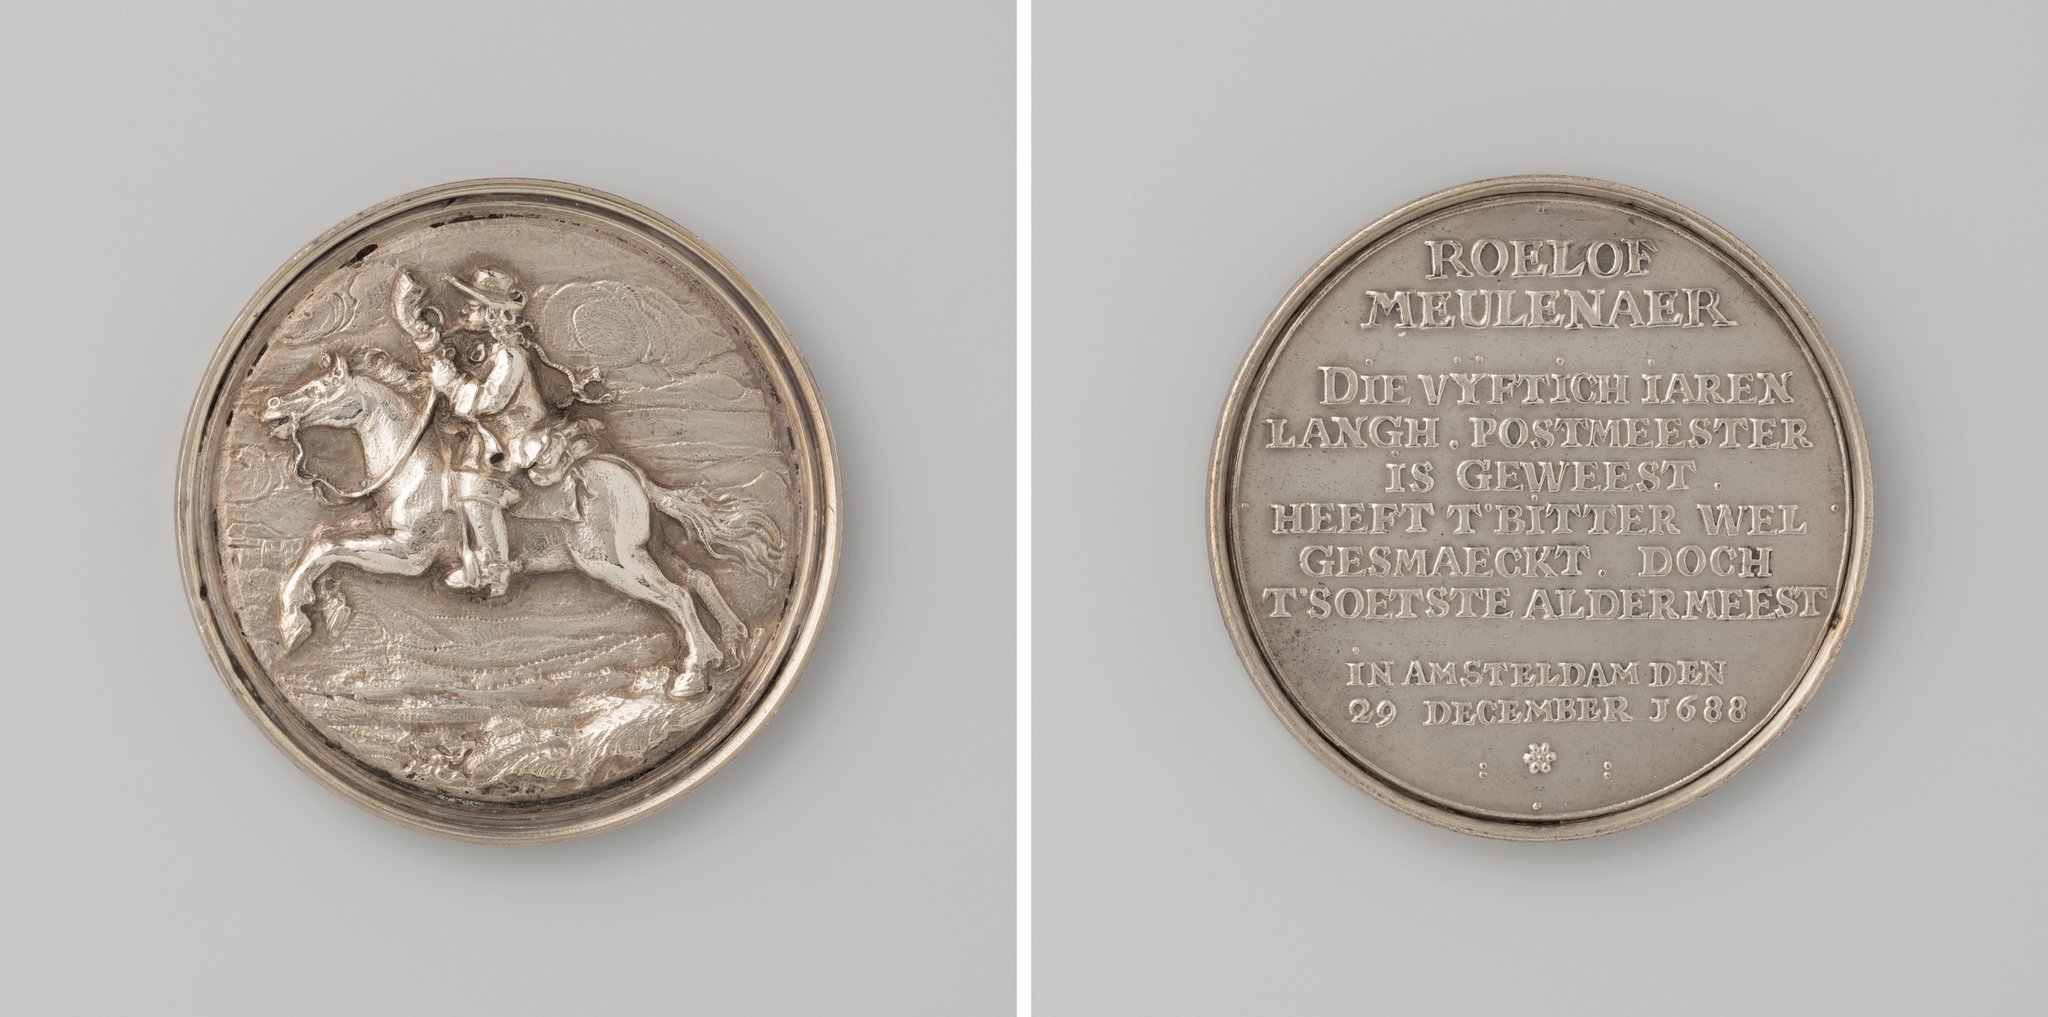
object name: history medal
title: Roelof Meulenaar, vijftig jaar postmeester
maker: Anonymous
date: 1688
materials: silver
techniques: striking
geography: amsterdam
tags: roelof meulenaar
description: Zilveren penning met losse achterzijde. Voorzijde: postruiter die op hoorn blaast. Keerzijde: opschrift